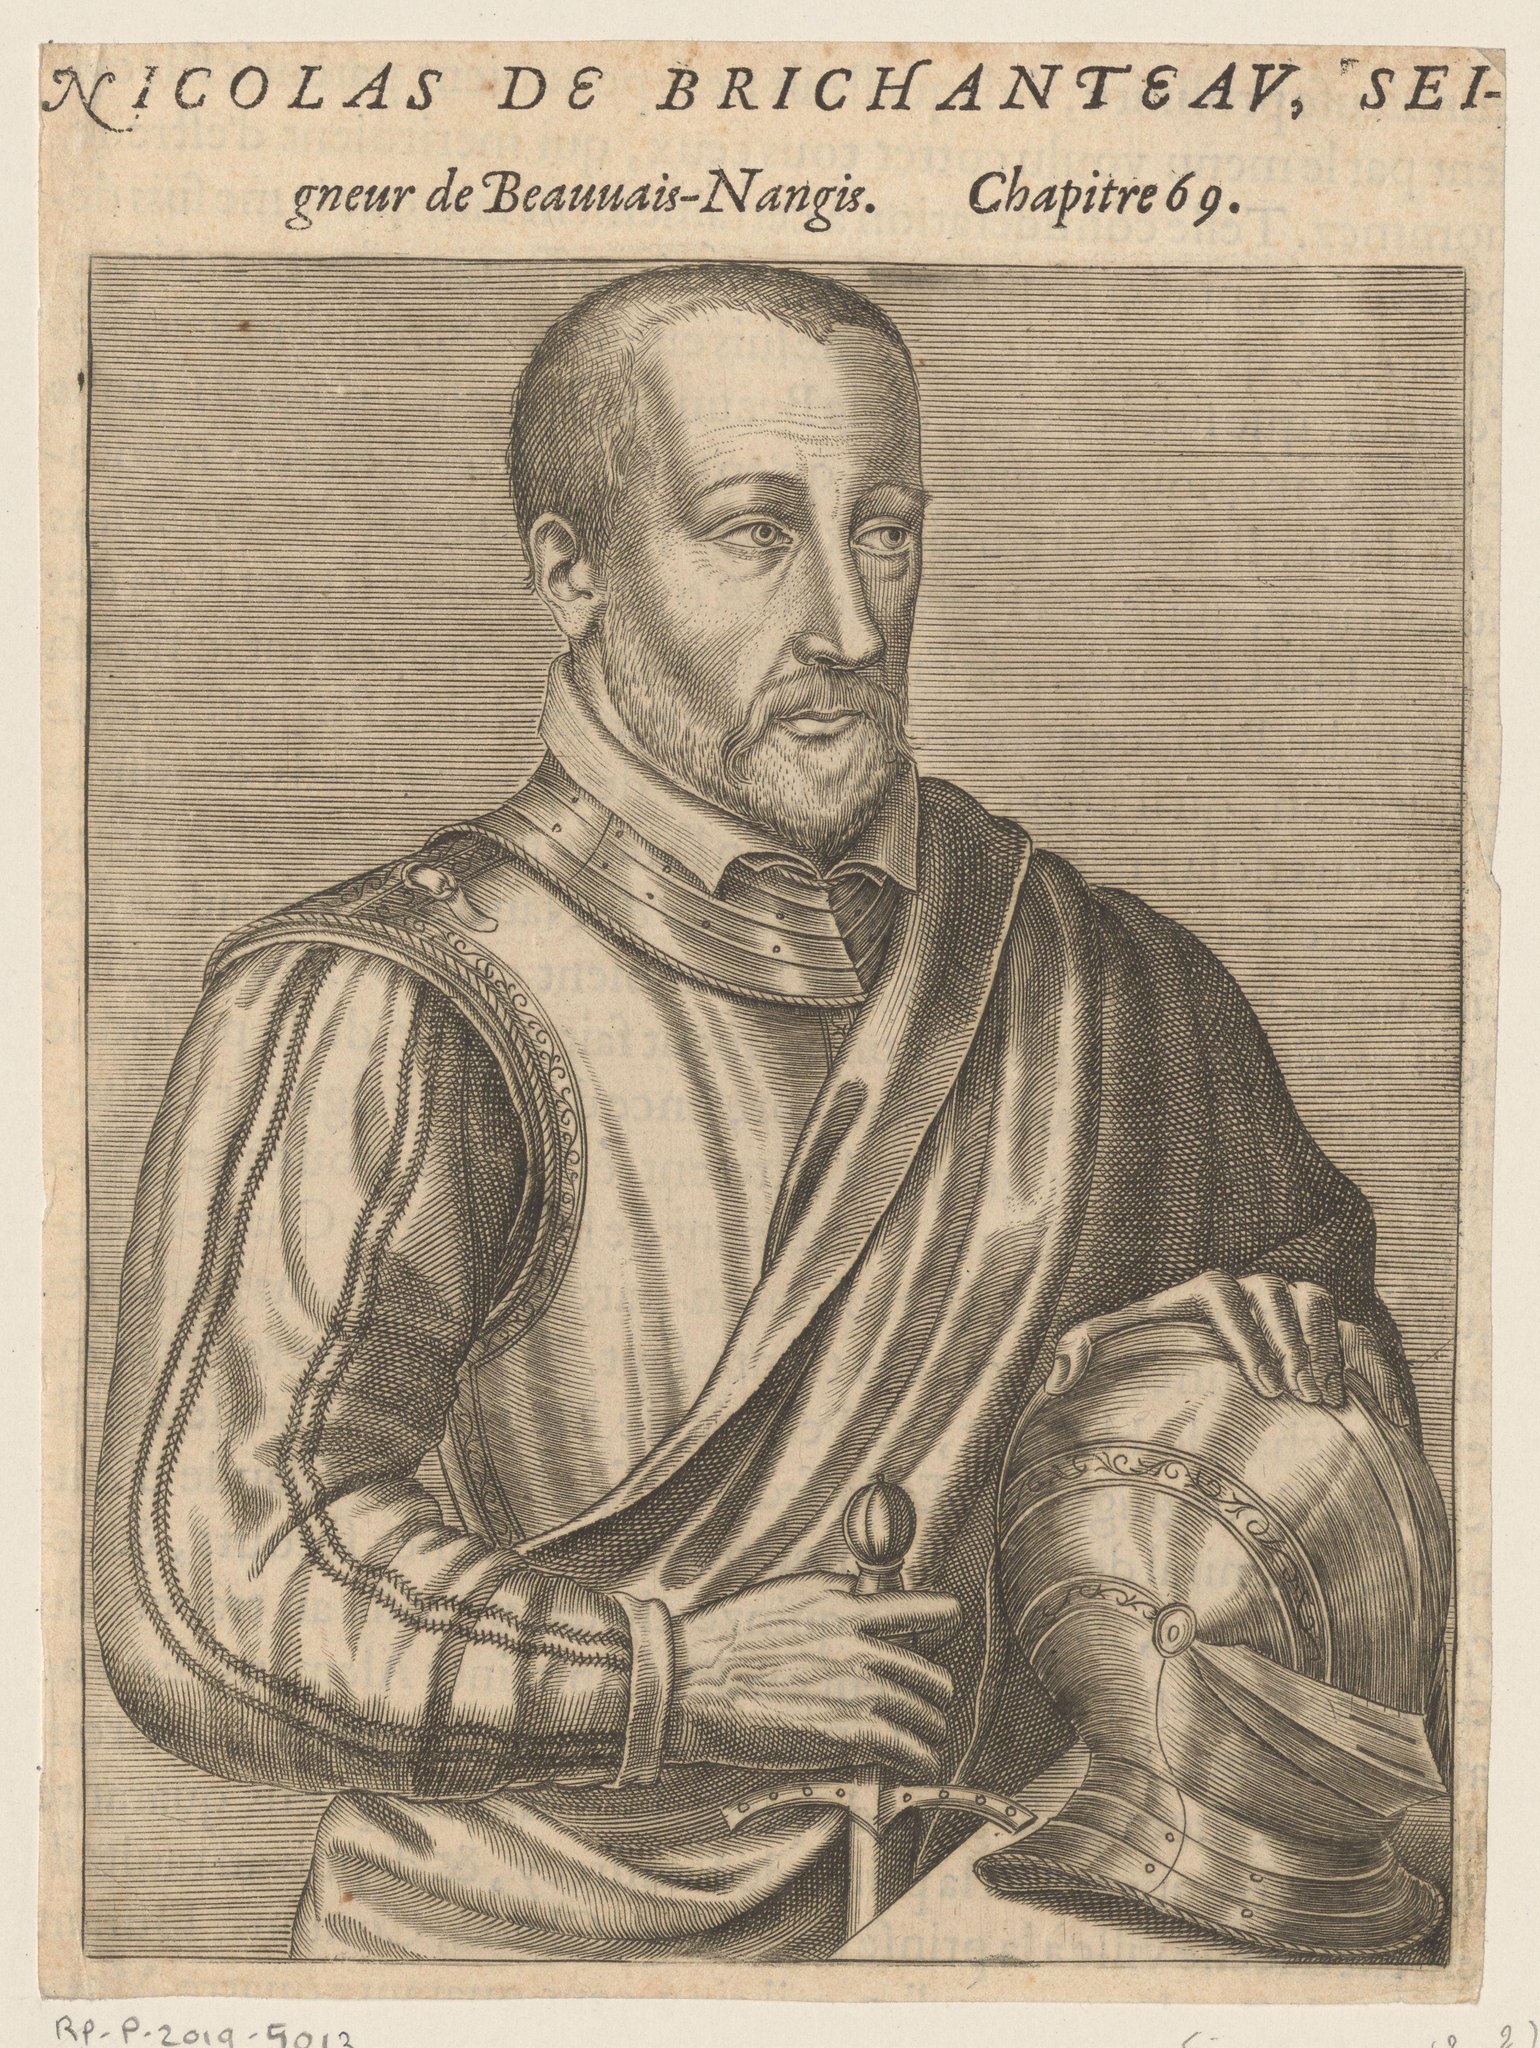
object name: print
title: Portret van Nicolas de Brichanteau de Beauvais-Nangis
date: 1584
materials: paper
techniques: engraving, etching, letterpress printing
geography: paris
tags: helmet, historical persons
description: Prent uit: Thevet, André. Les vrais pourtraits et vies des hommes illustres grecz, latins et payens (...). Parijs: weduwe Jacques Kerver en Guillaume Chaudière, 1584, dl. 2, f. 431.